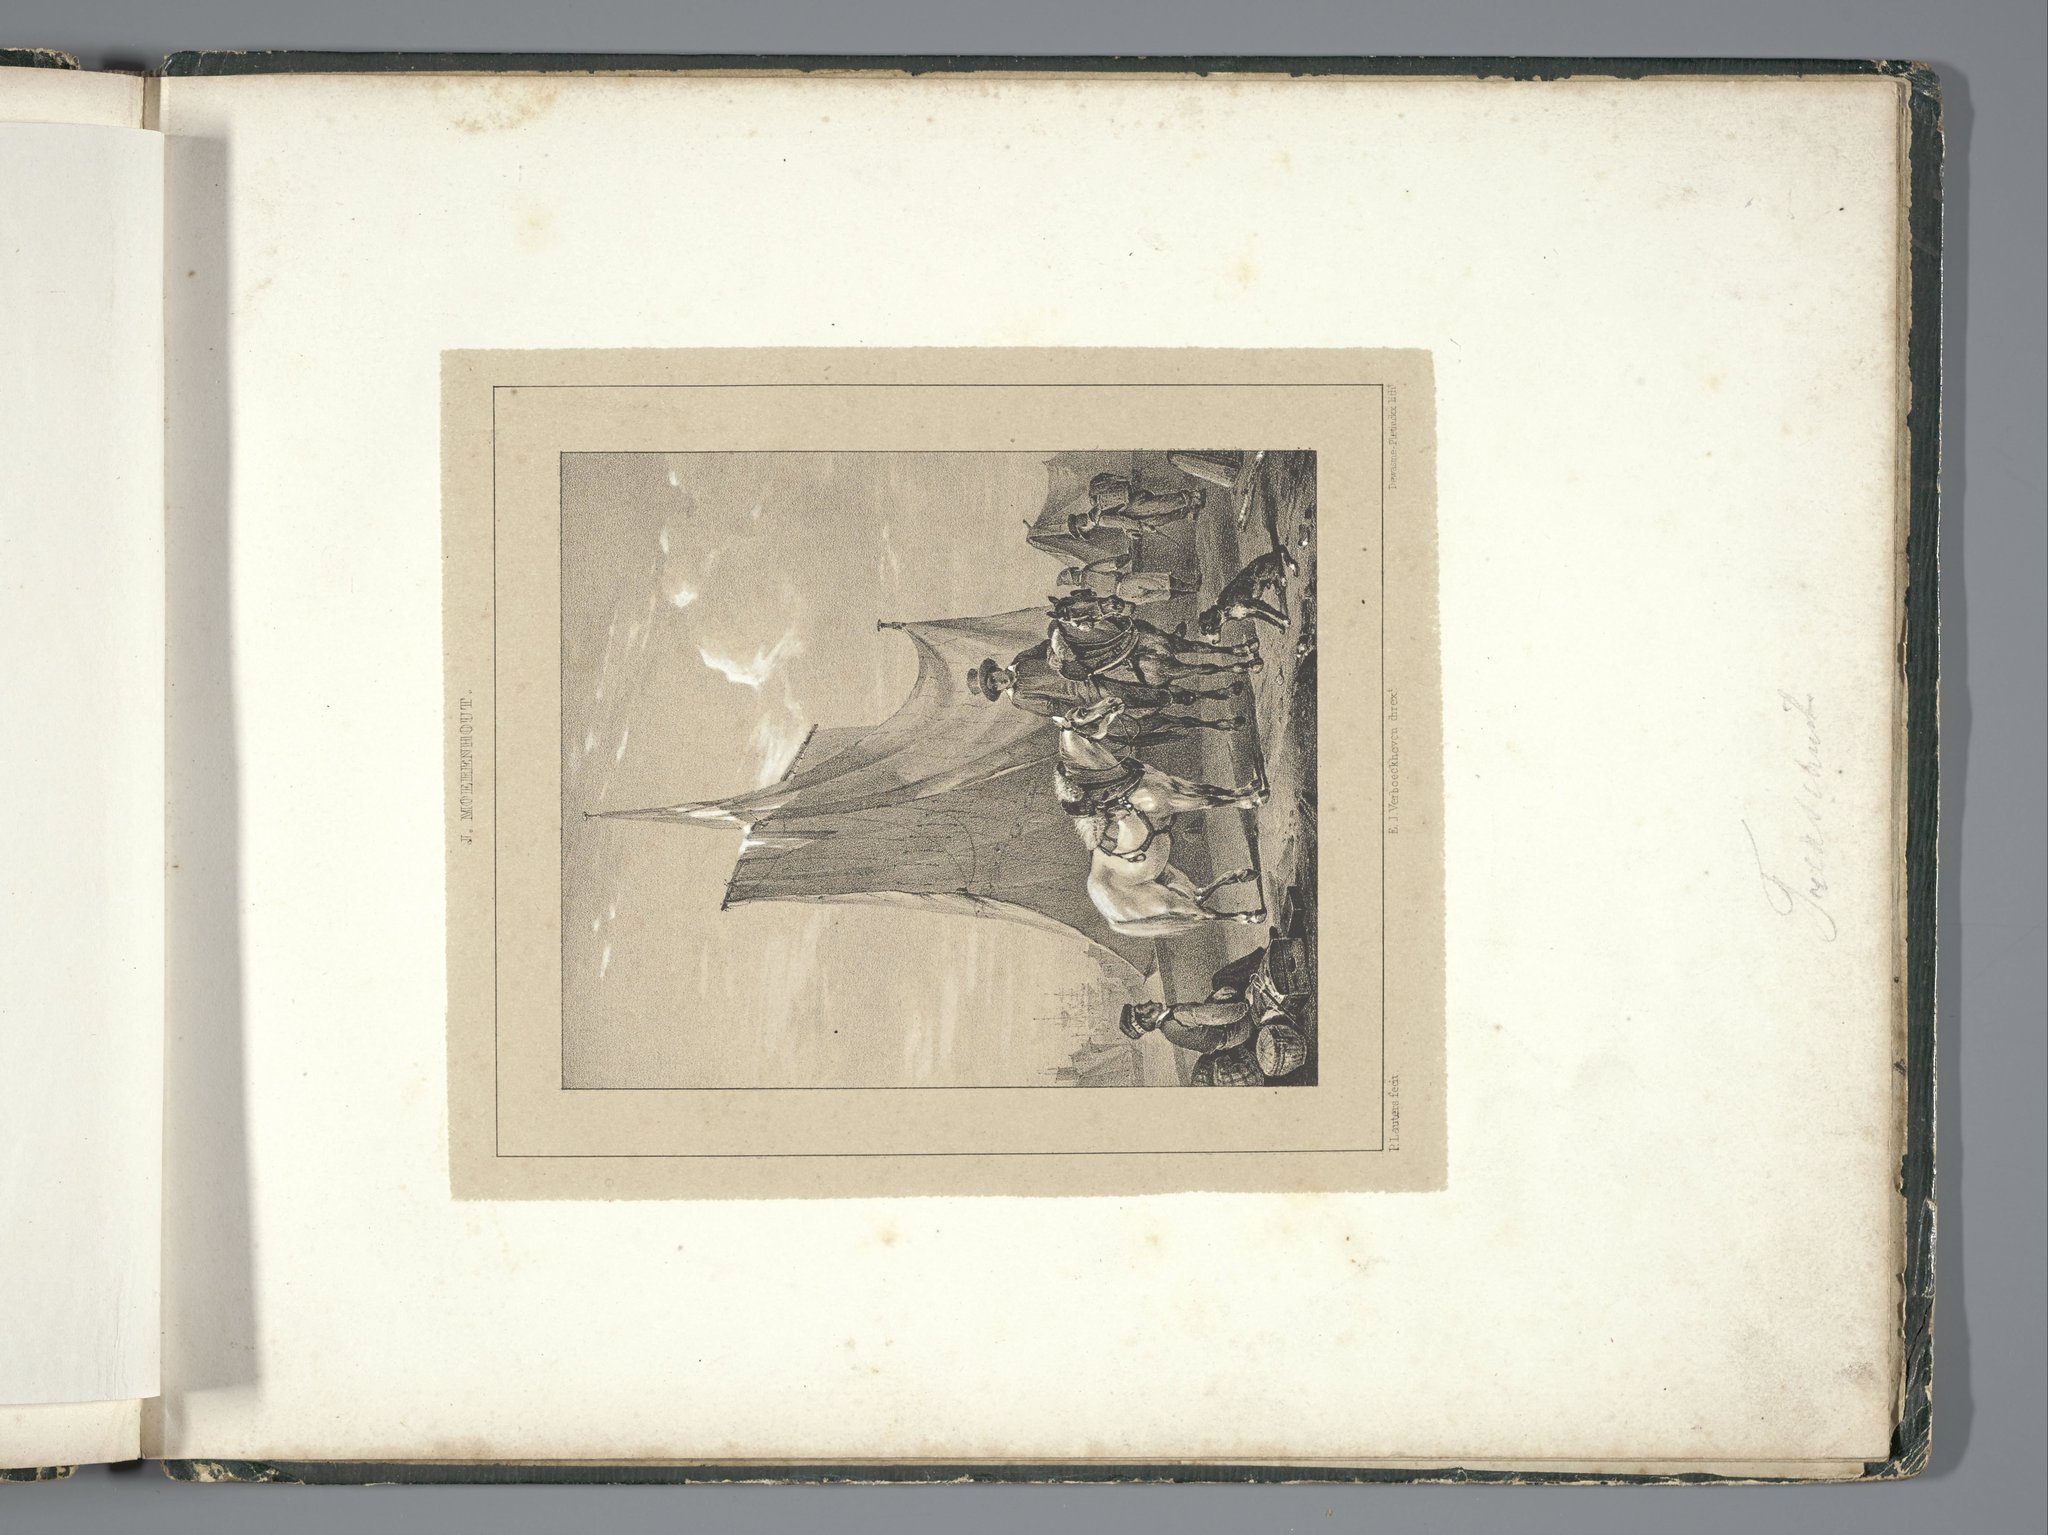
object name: print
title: Trekschuit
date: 1830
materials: paper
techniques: lithograph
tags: tow-boat, towing-barge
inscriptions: inscription: ‘Trekschuit’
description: Prent uit album met twaalf vroege lithografieën geproduceerd door de firma Dewasme-Pletinckx te Brussel naar J.C. Schotel, E.J. Verboeckhoven, B.J. van Hove en andere eigentijdse meesters in originele band.